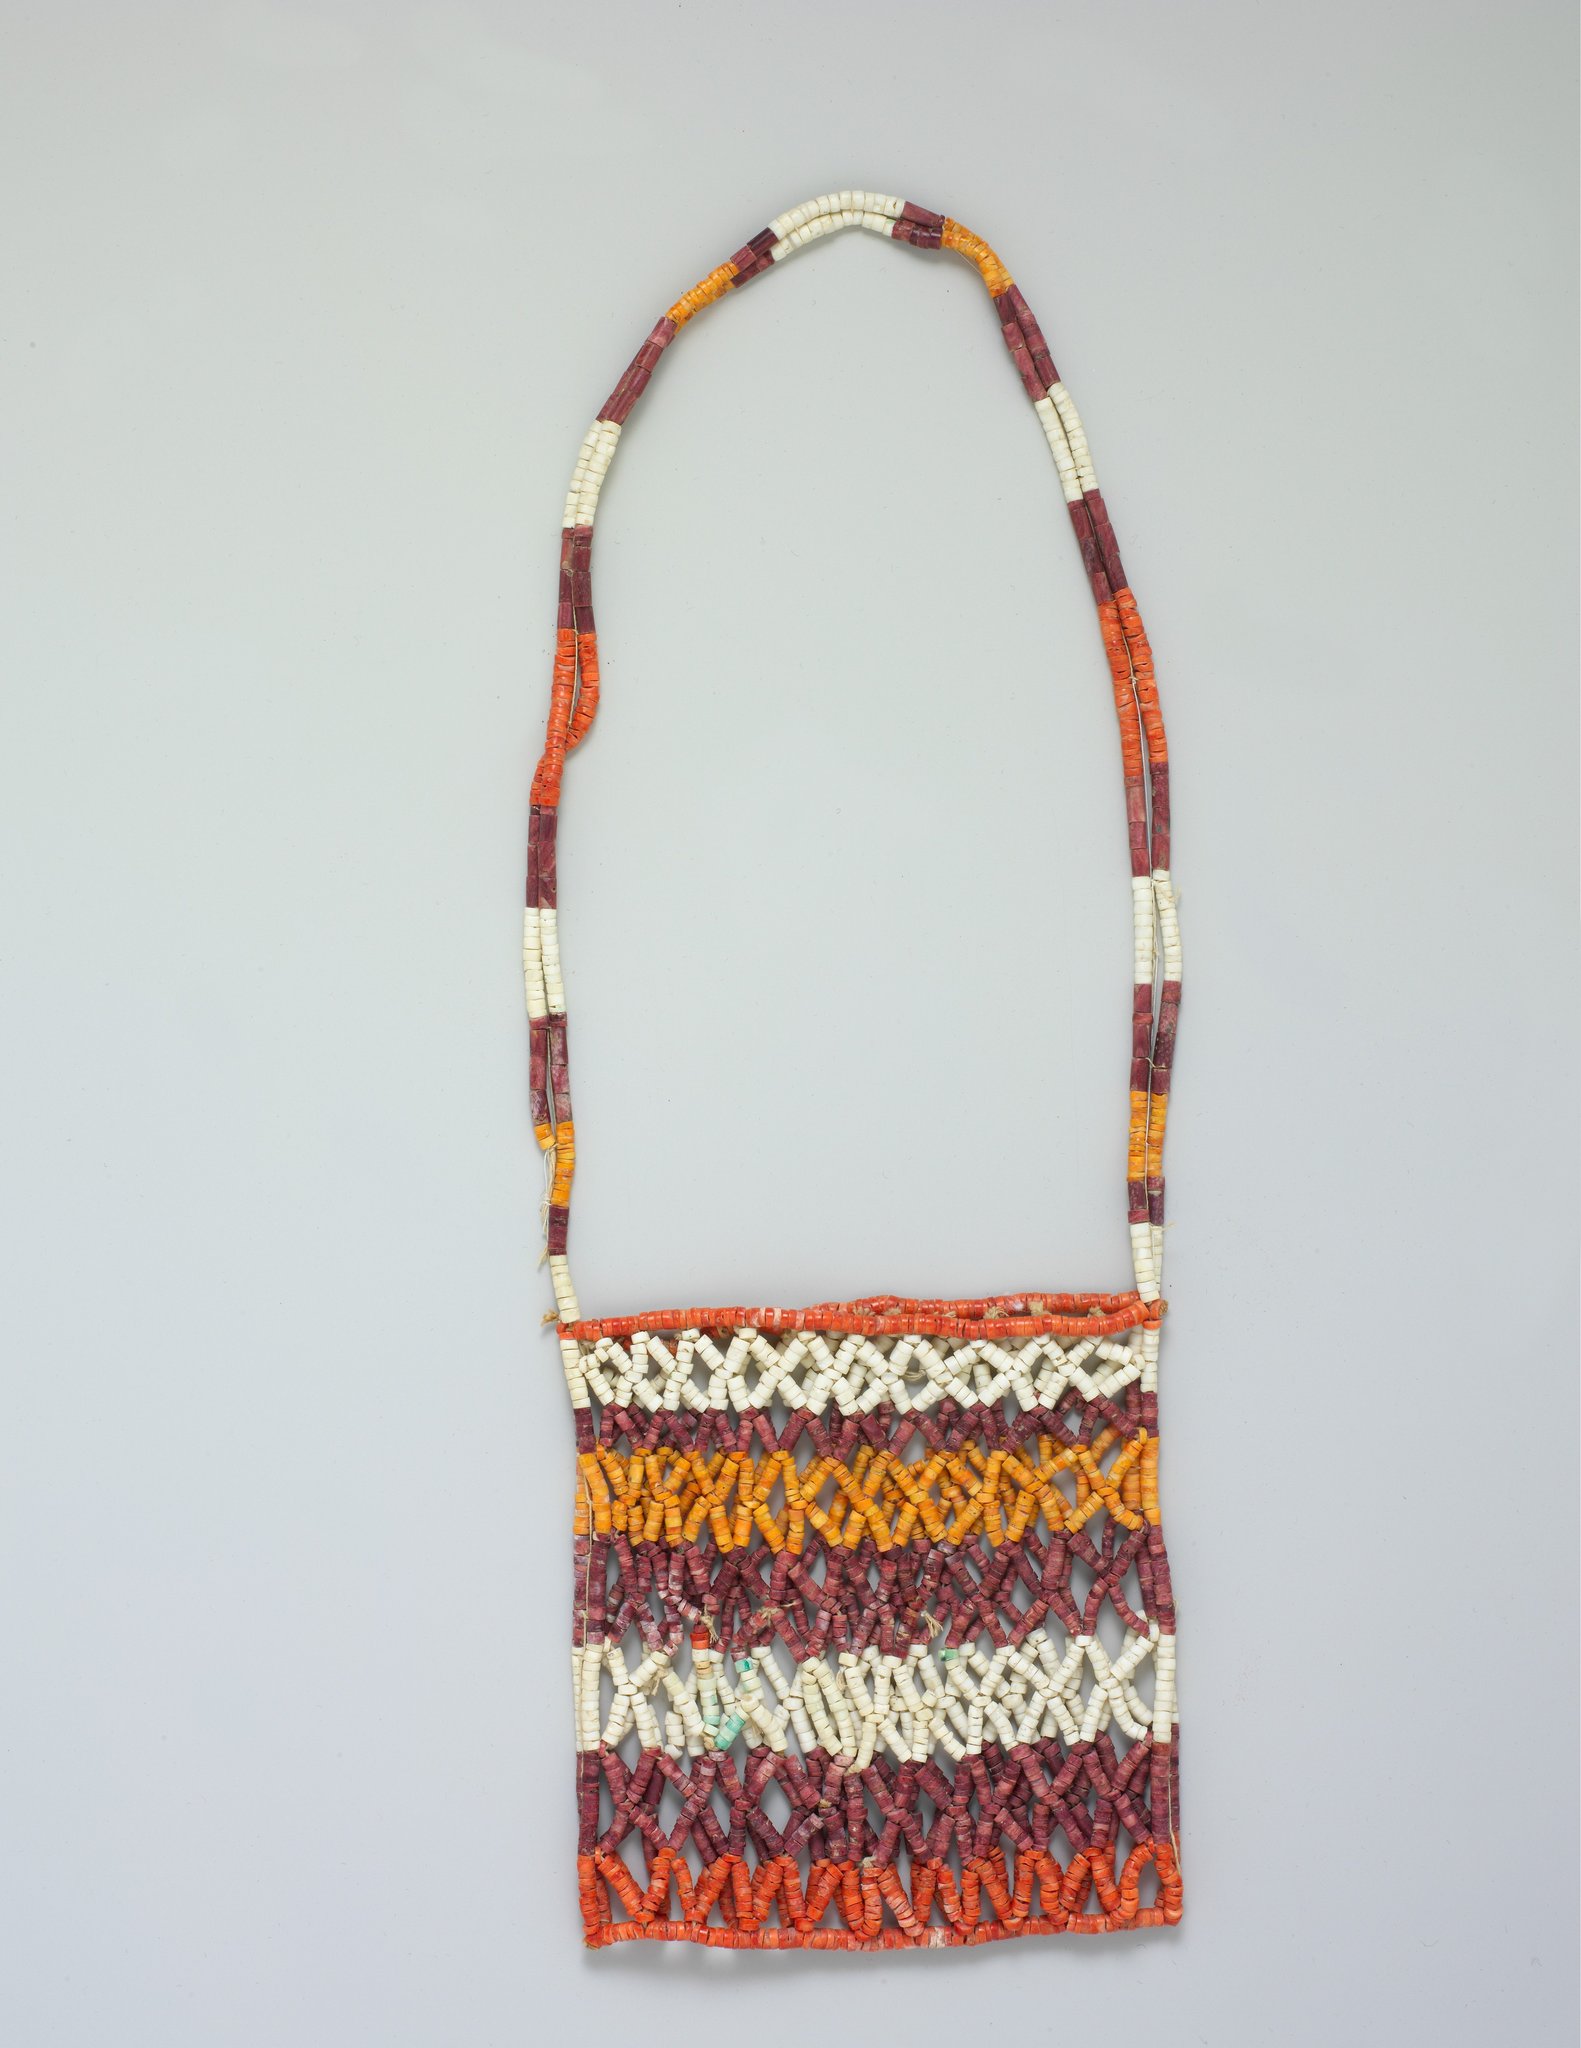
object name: bag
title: Bag with Shell Beads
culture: chancay or chimú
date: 1301-1500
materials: cotton, shell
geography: peru